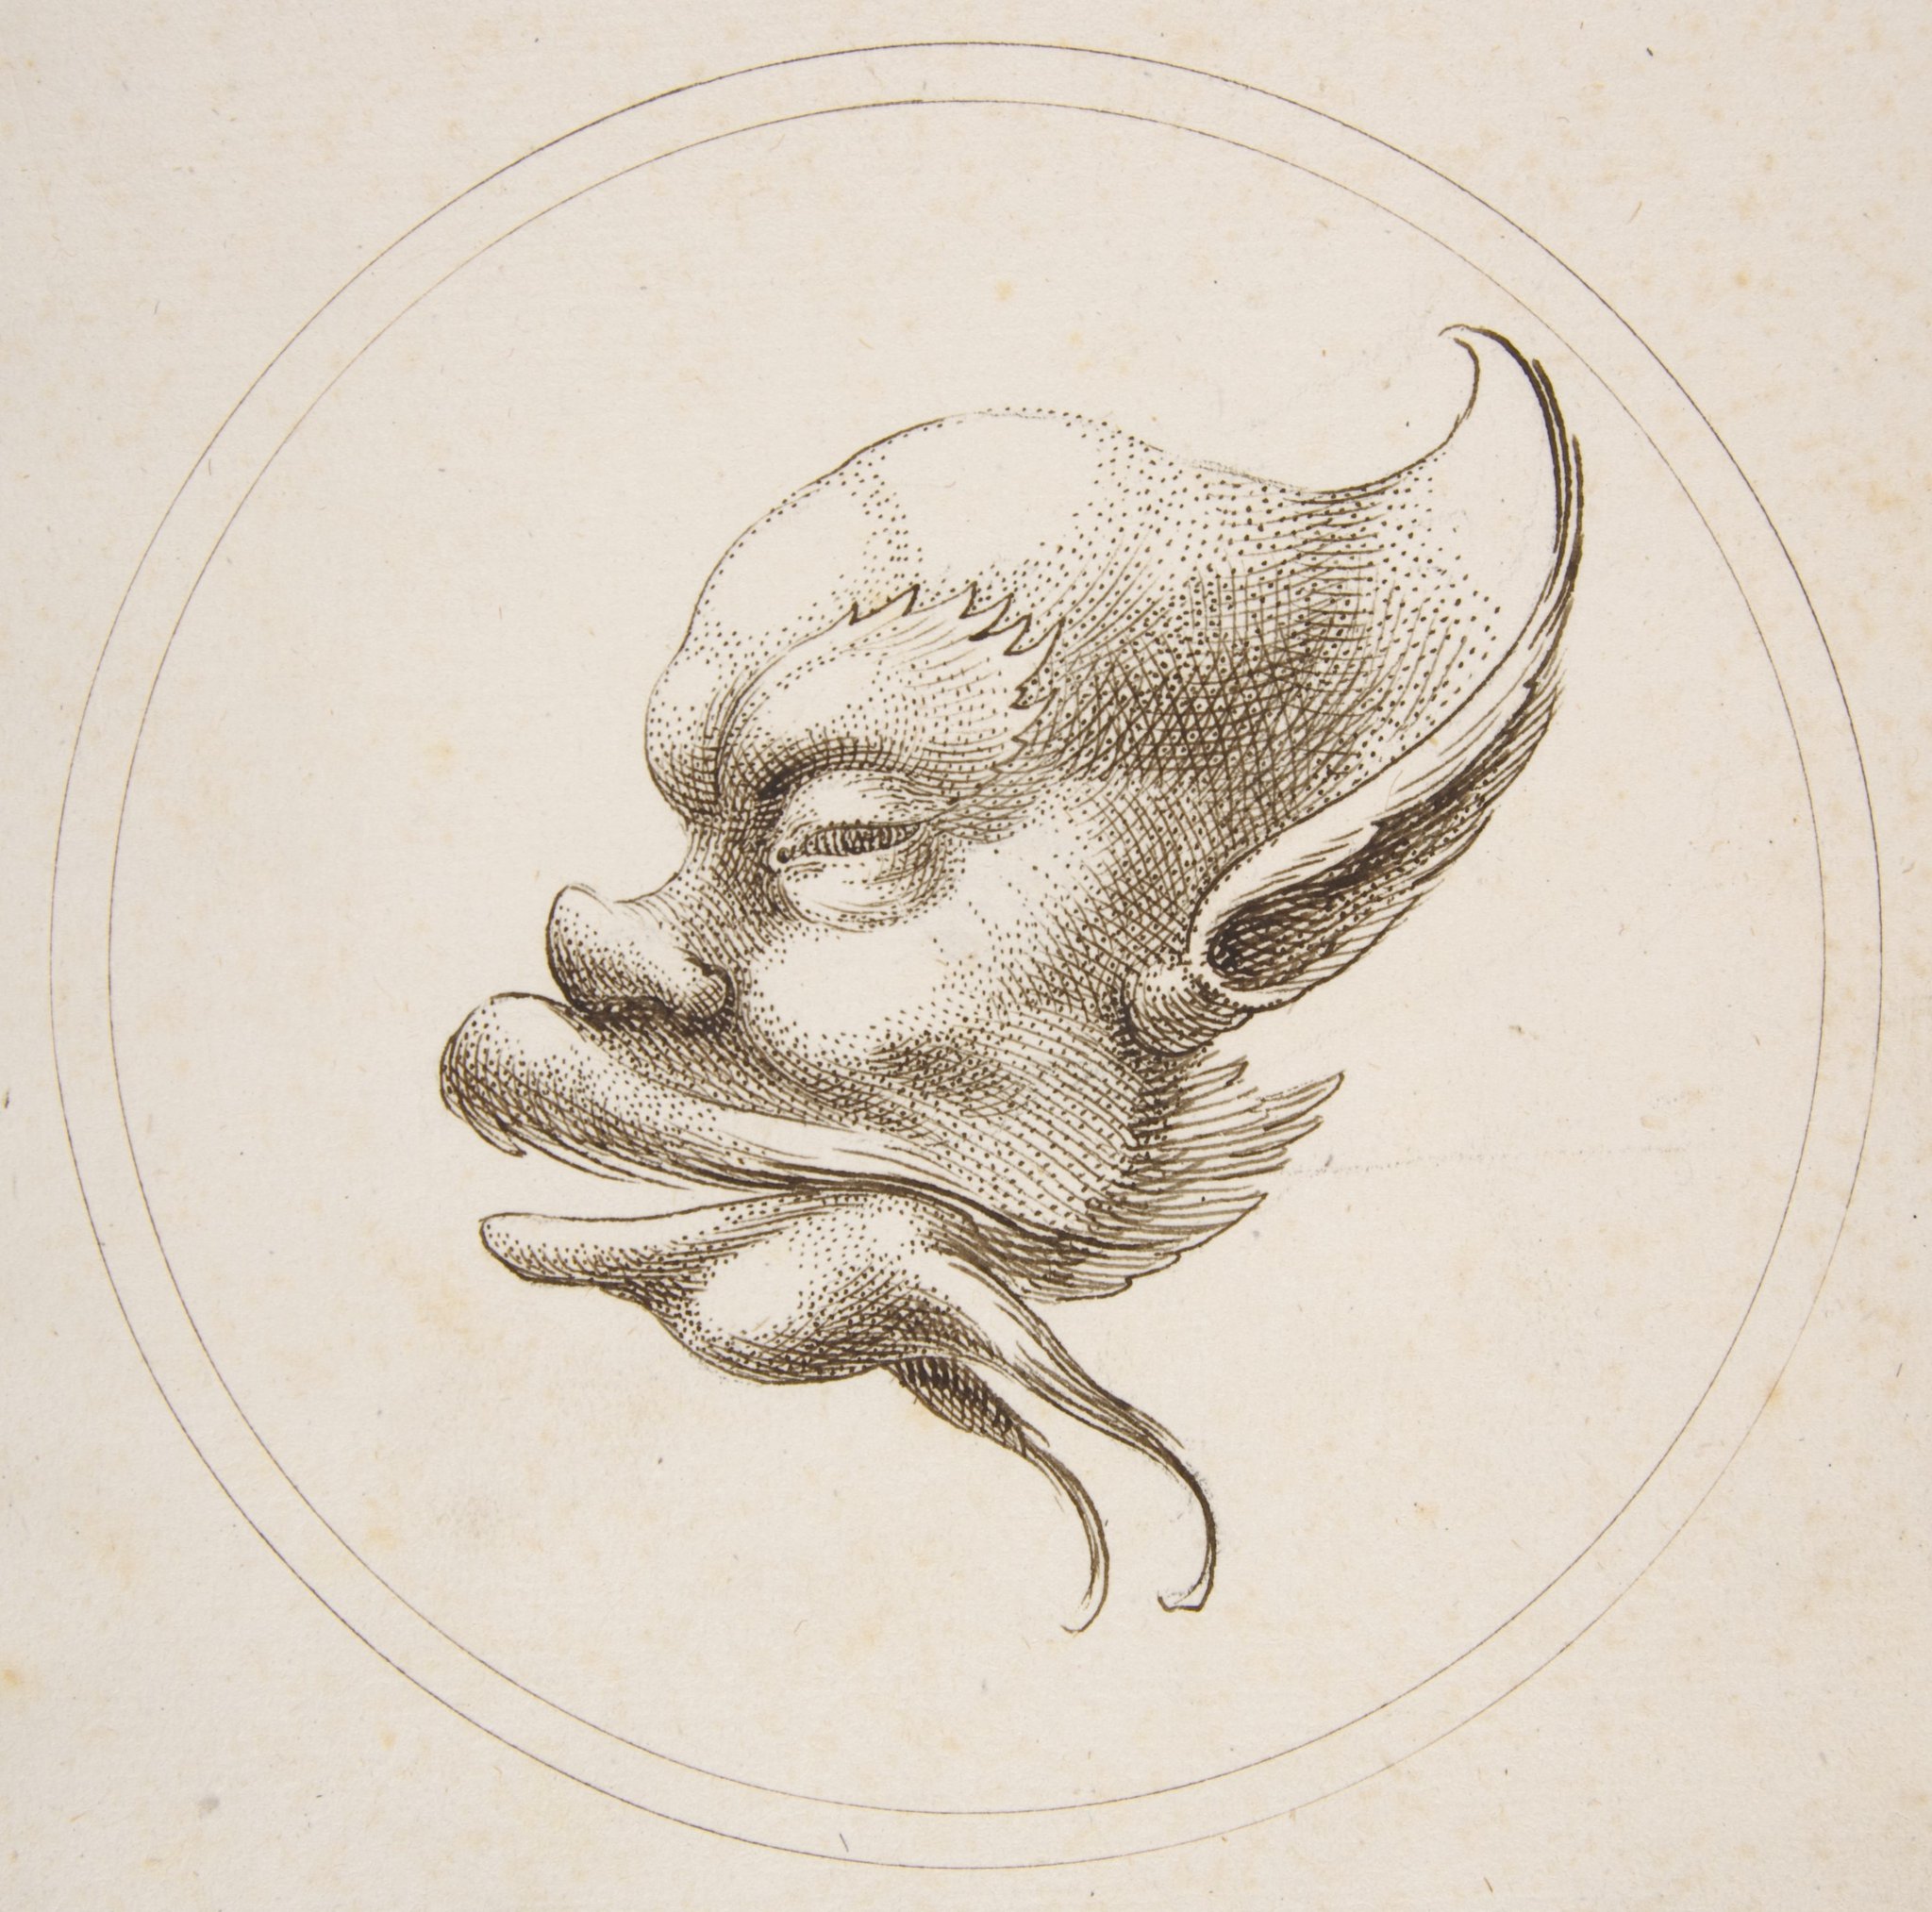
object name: drawing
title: Grotesque Head With a Large Eyebrow Looking to the Left Within a Circle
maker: gaetano piccini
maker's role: artist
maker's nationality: italian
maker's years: 1710-1730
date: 1727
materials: ink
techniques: pen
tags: heads